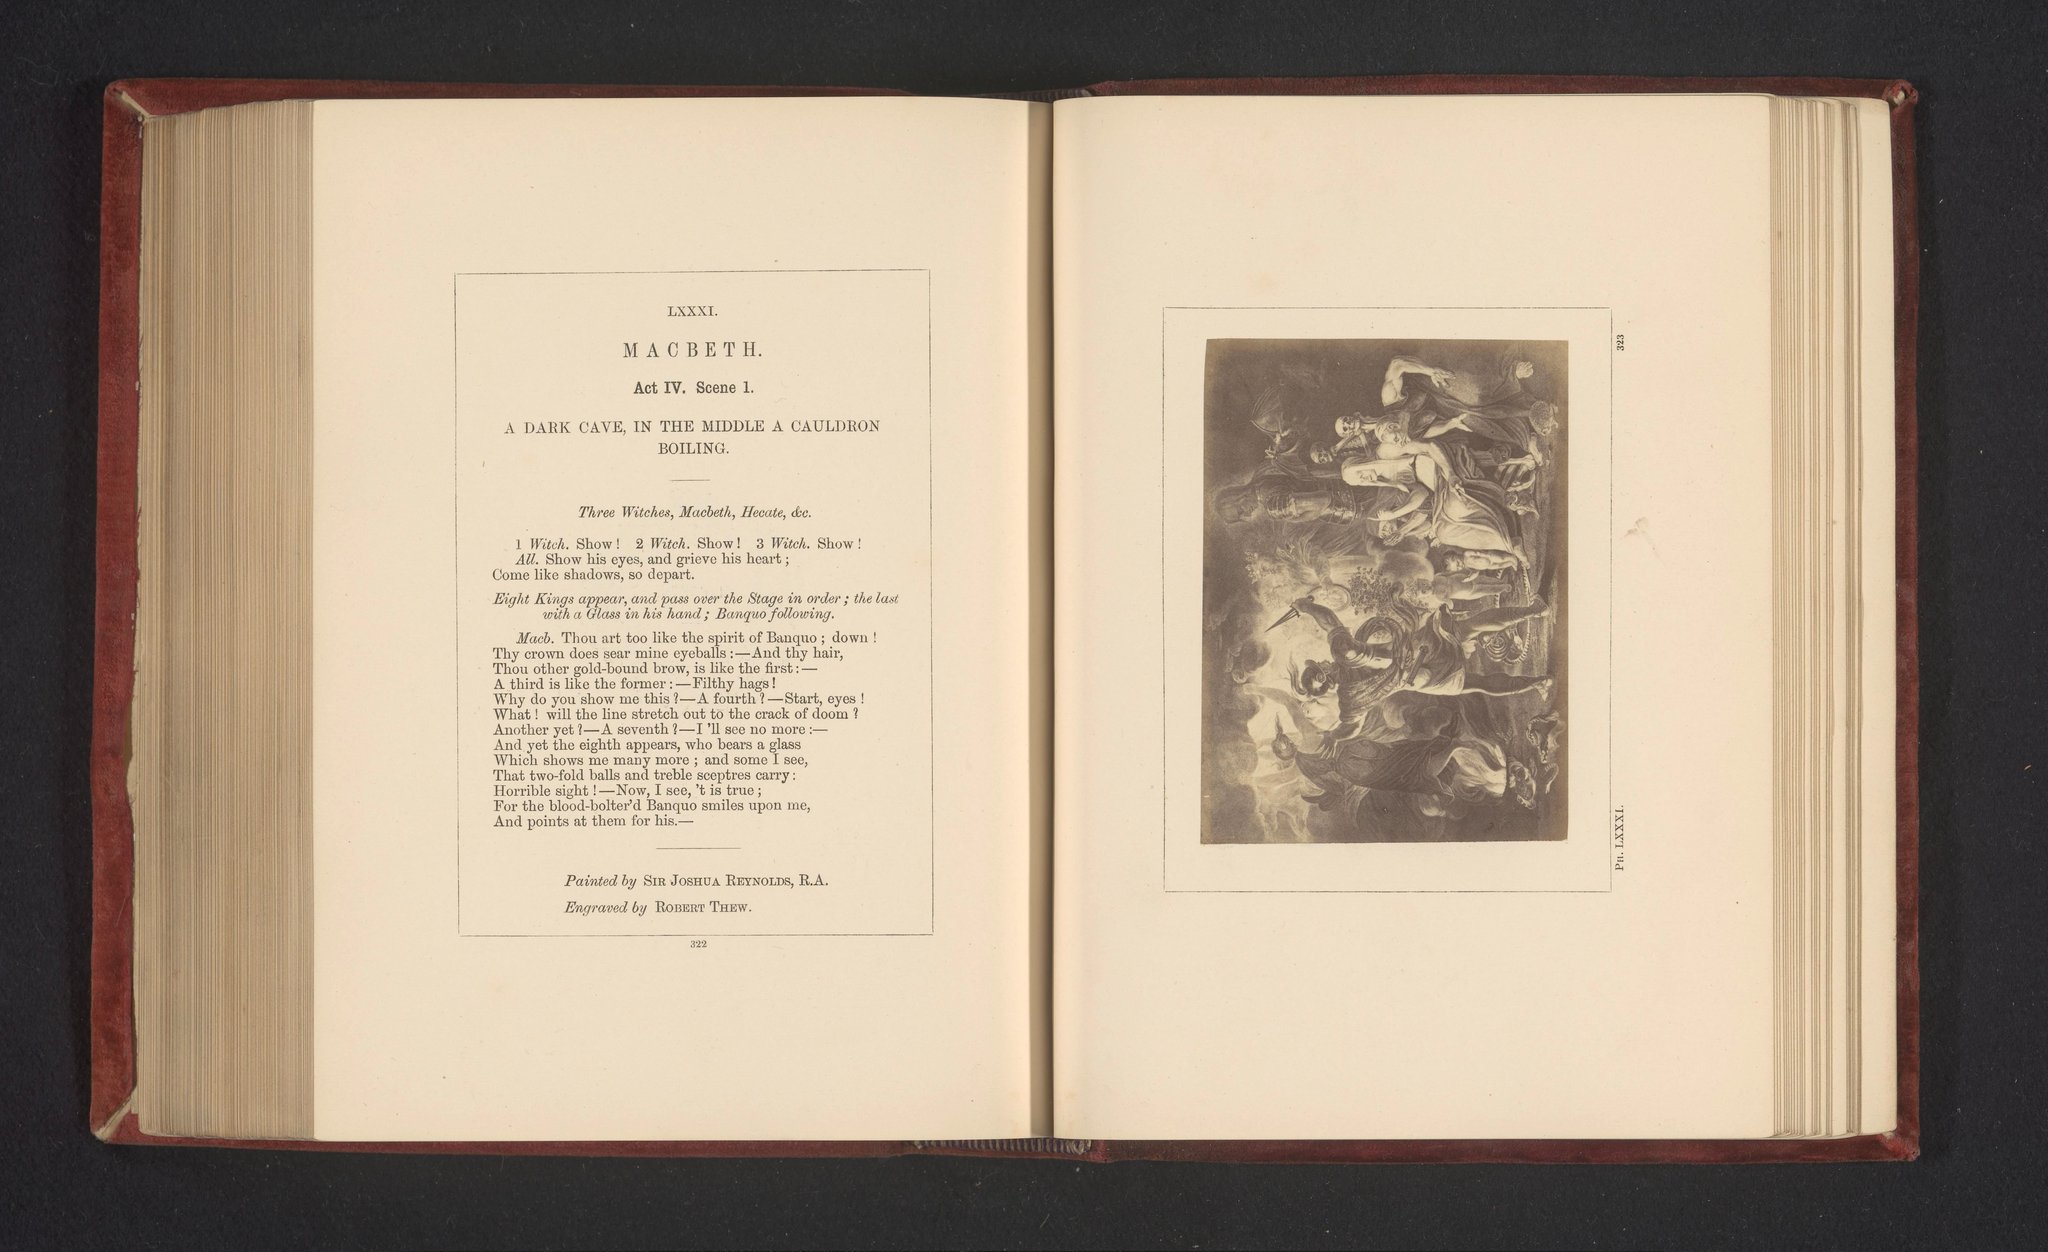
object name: page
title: Fotoreproductie van een prent naar een schilderij door Joshua Reynolds, voorstellend een scene uit Macbeth door William Shakespeare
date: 1854-1864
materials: photographic support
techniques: albumen print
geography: london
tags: macbeth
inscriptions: number: ‘Ph. LXXXI. 323’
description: Te zien is akte IV, scene 1 met Macbeth in een grot met de drie heksen.